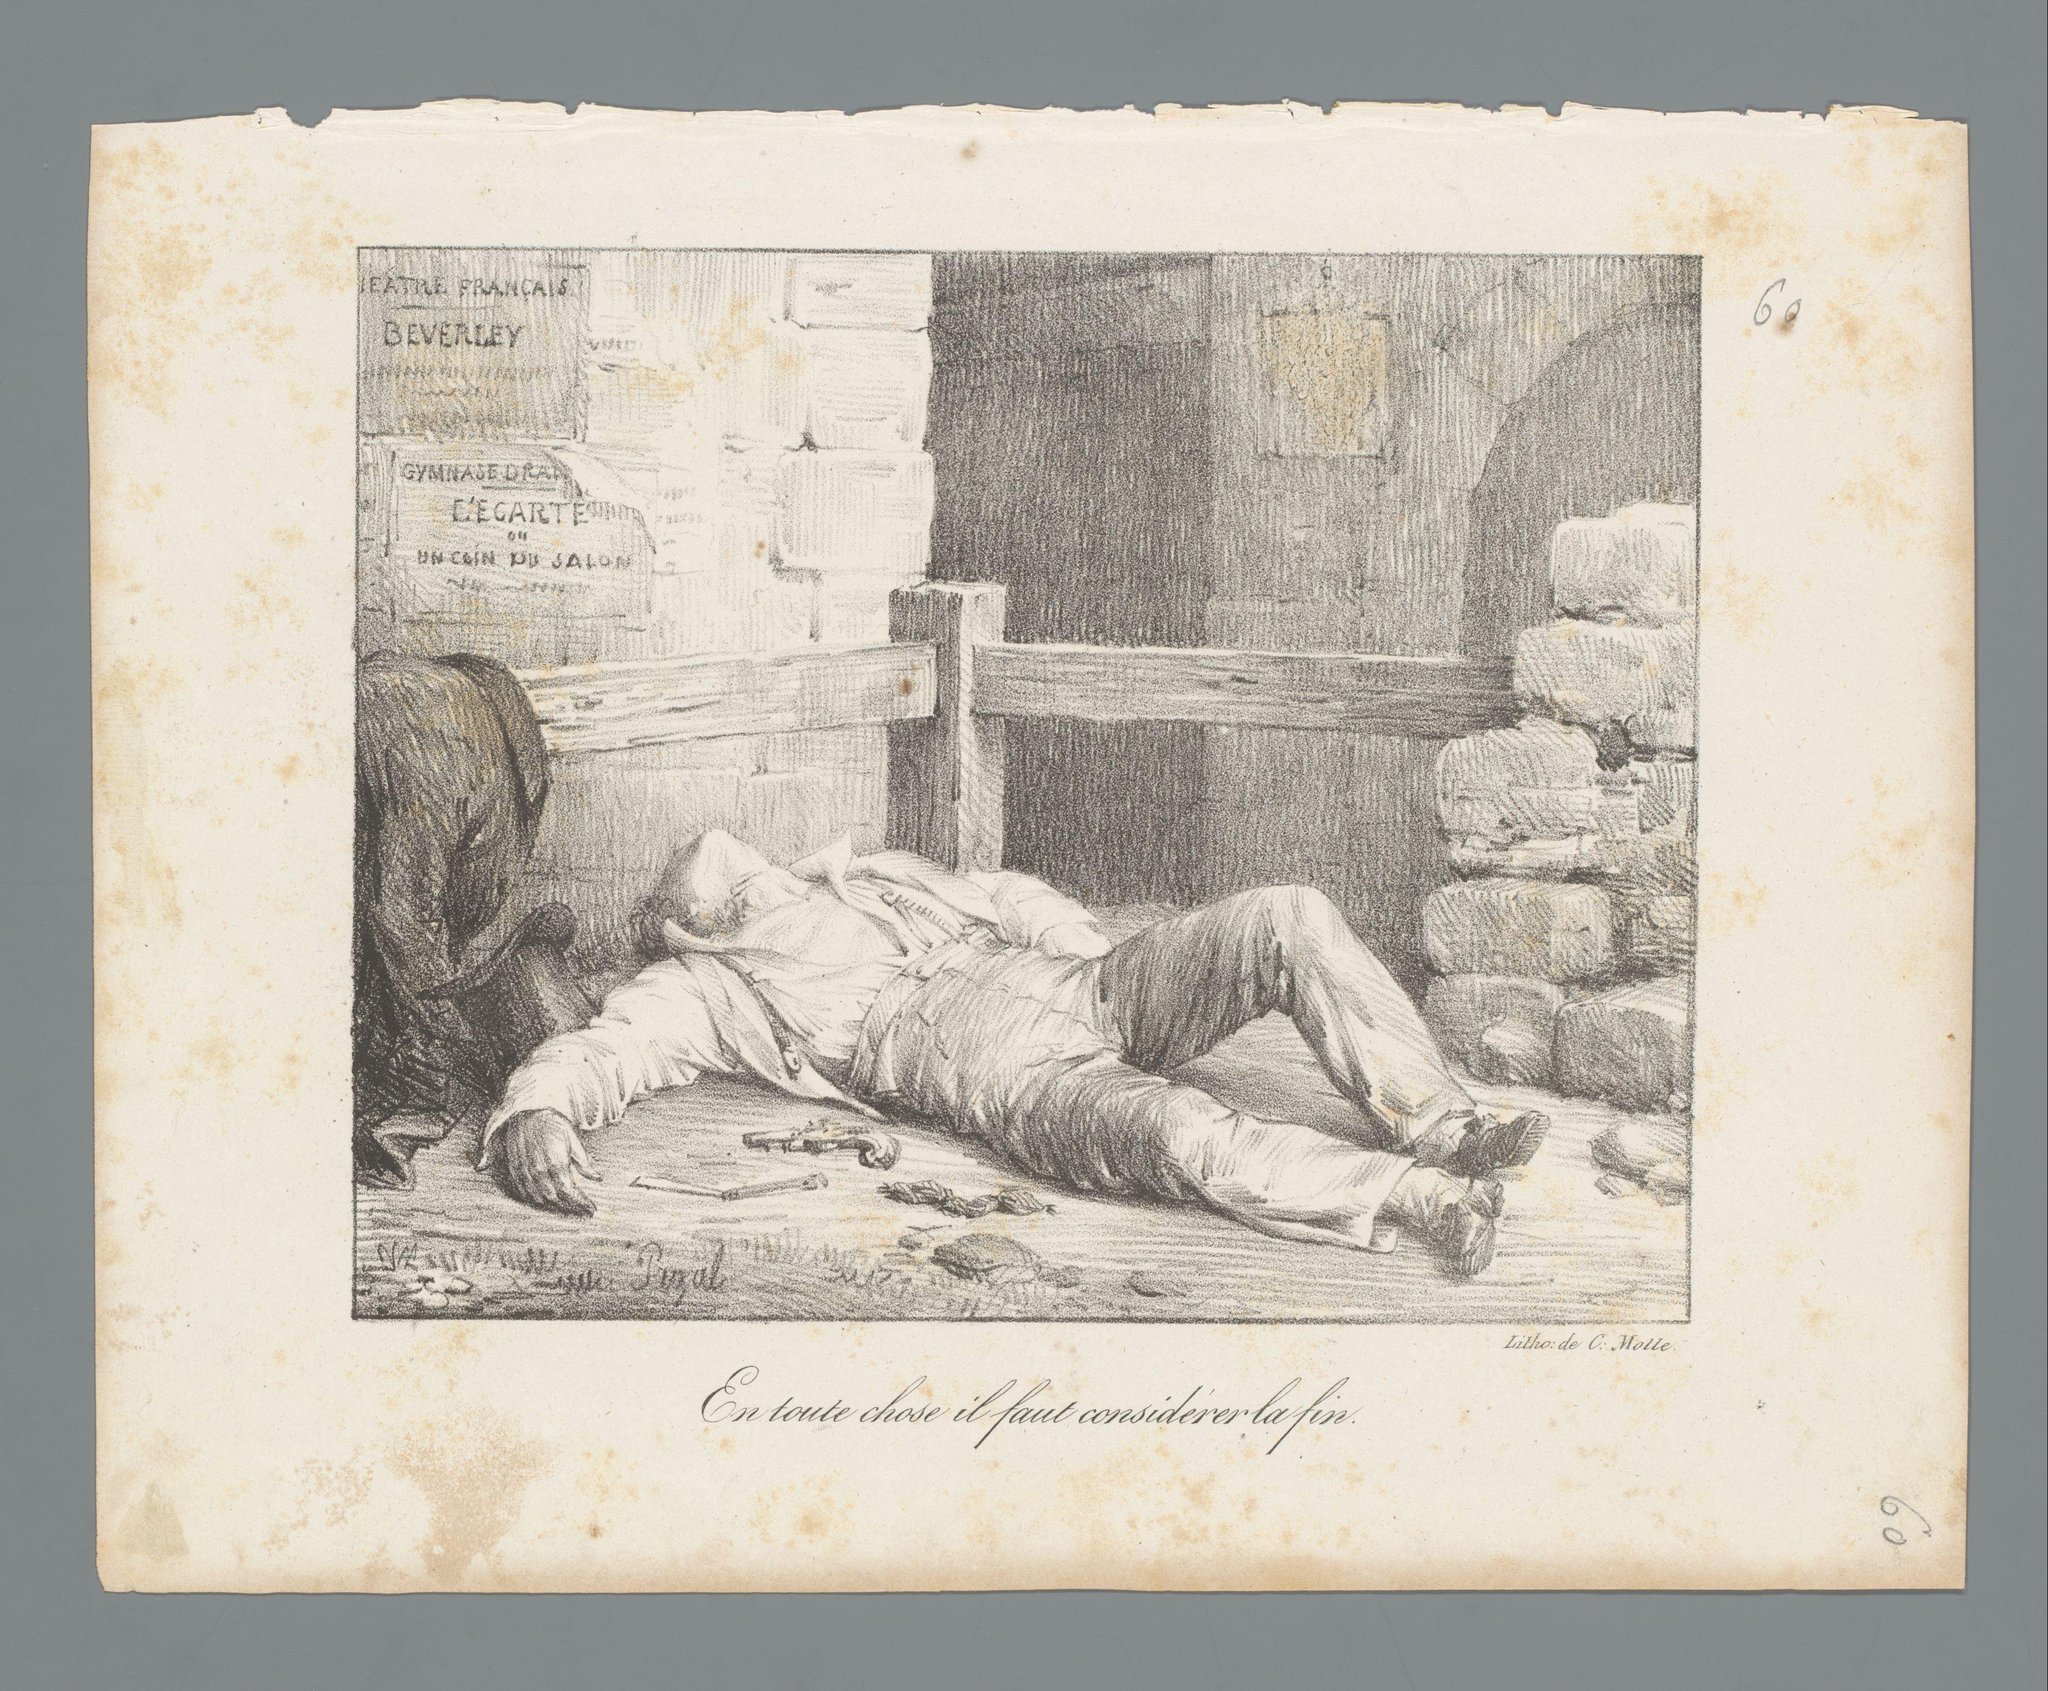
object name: print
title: En toute chose il faut considérer la fin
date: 1823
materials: paper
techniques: lithograph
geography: paris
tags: adult man (+ lying), firearms (with name)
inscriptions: collector's mark: Lugt 2228